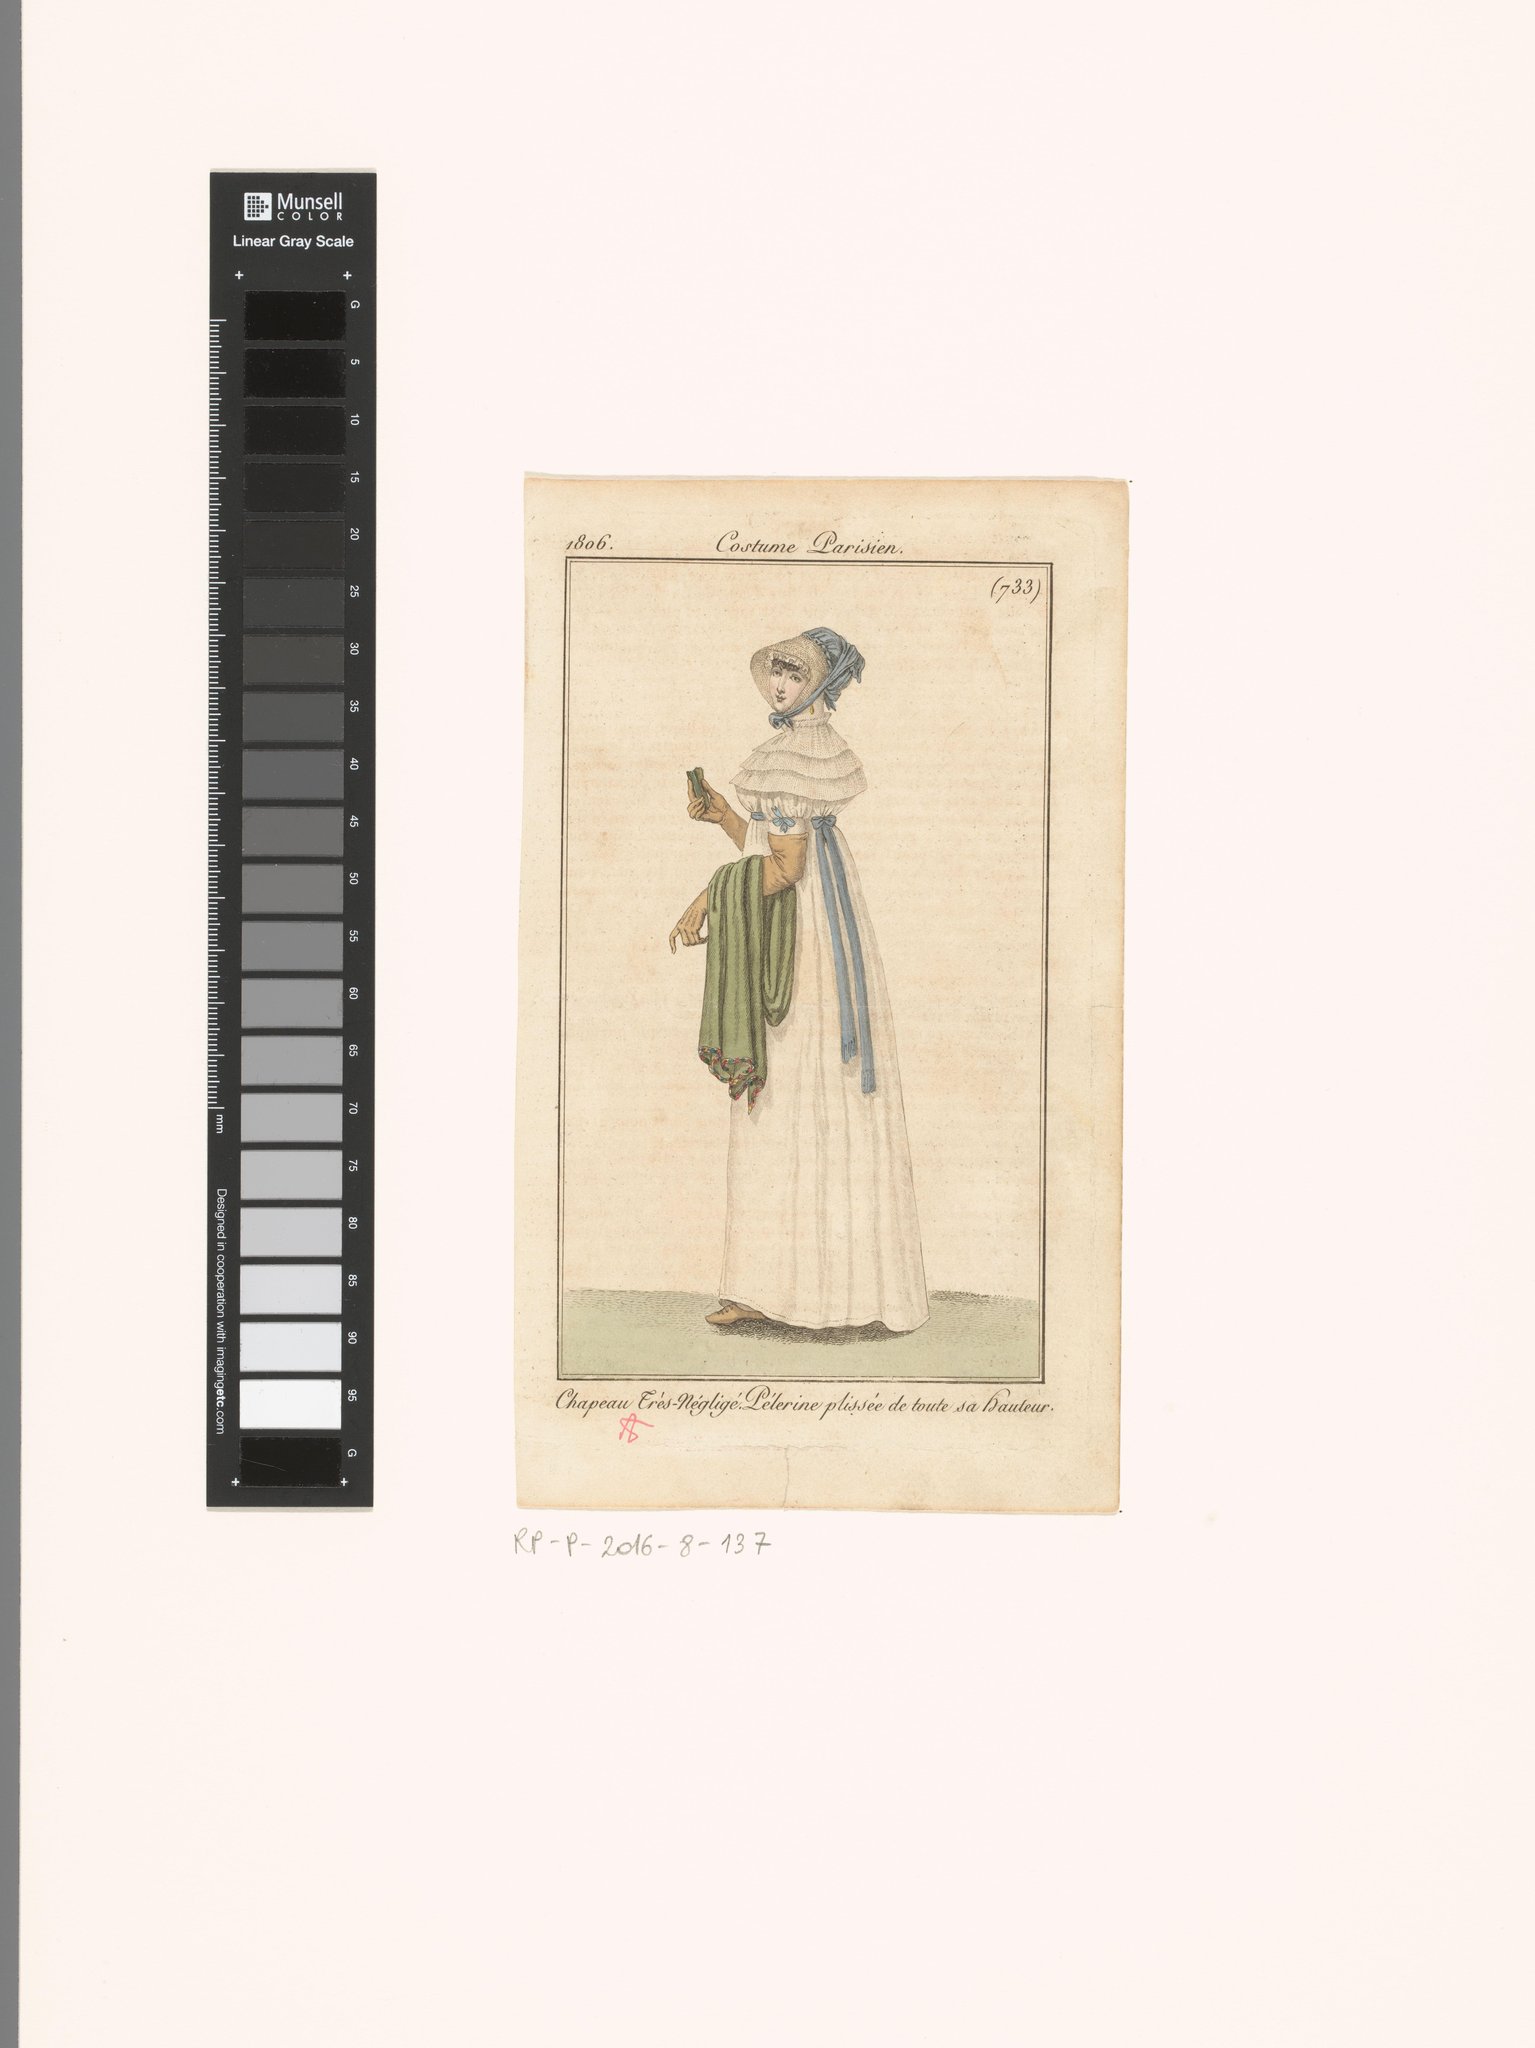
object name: fashion print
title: Journal des Dames et des modes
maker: Anonymous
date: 1806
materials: paper, ink, watercolor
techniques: etching, hand coloring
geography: france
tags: fashion plates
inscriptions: collector's mark: Lugt 2228